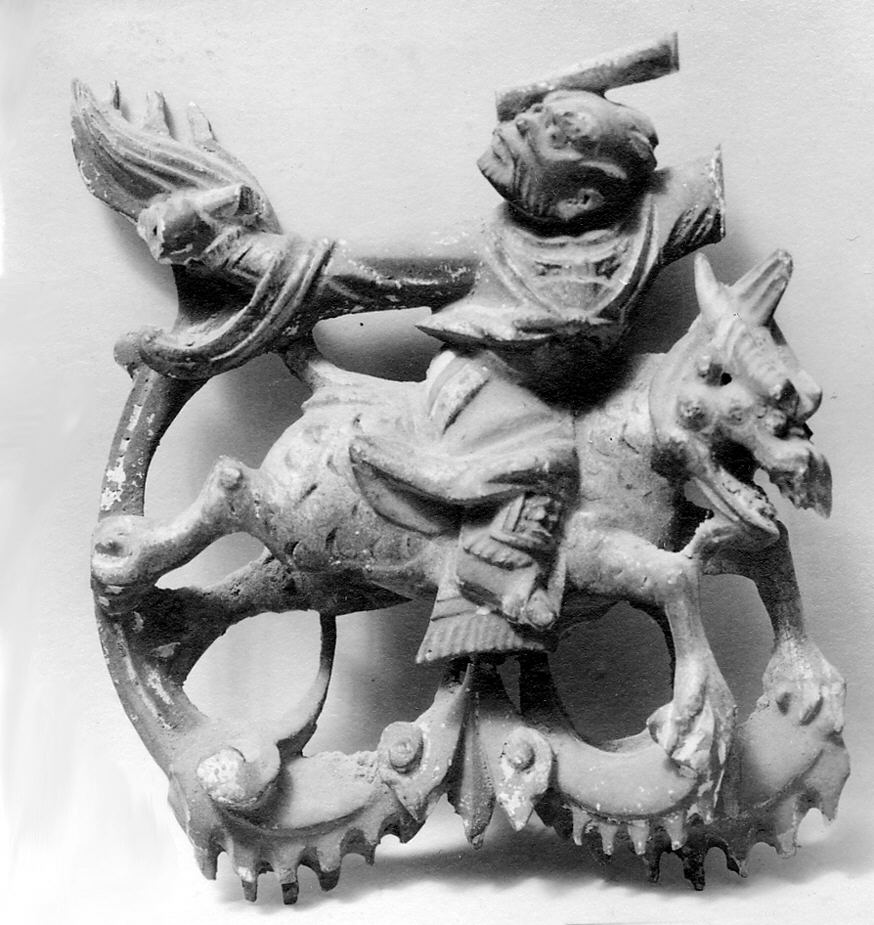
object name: statuette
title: Man Mounted on Qilin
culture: chinese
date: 1368-1644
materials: wood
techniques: painting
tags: men